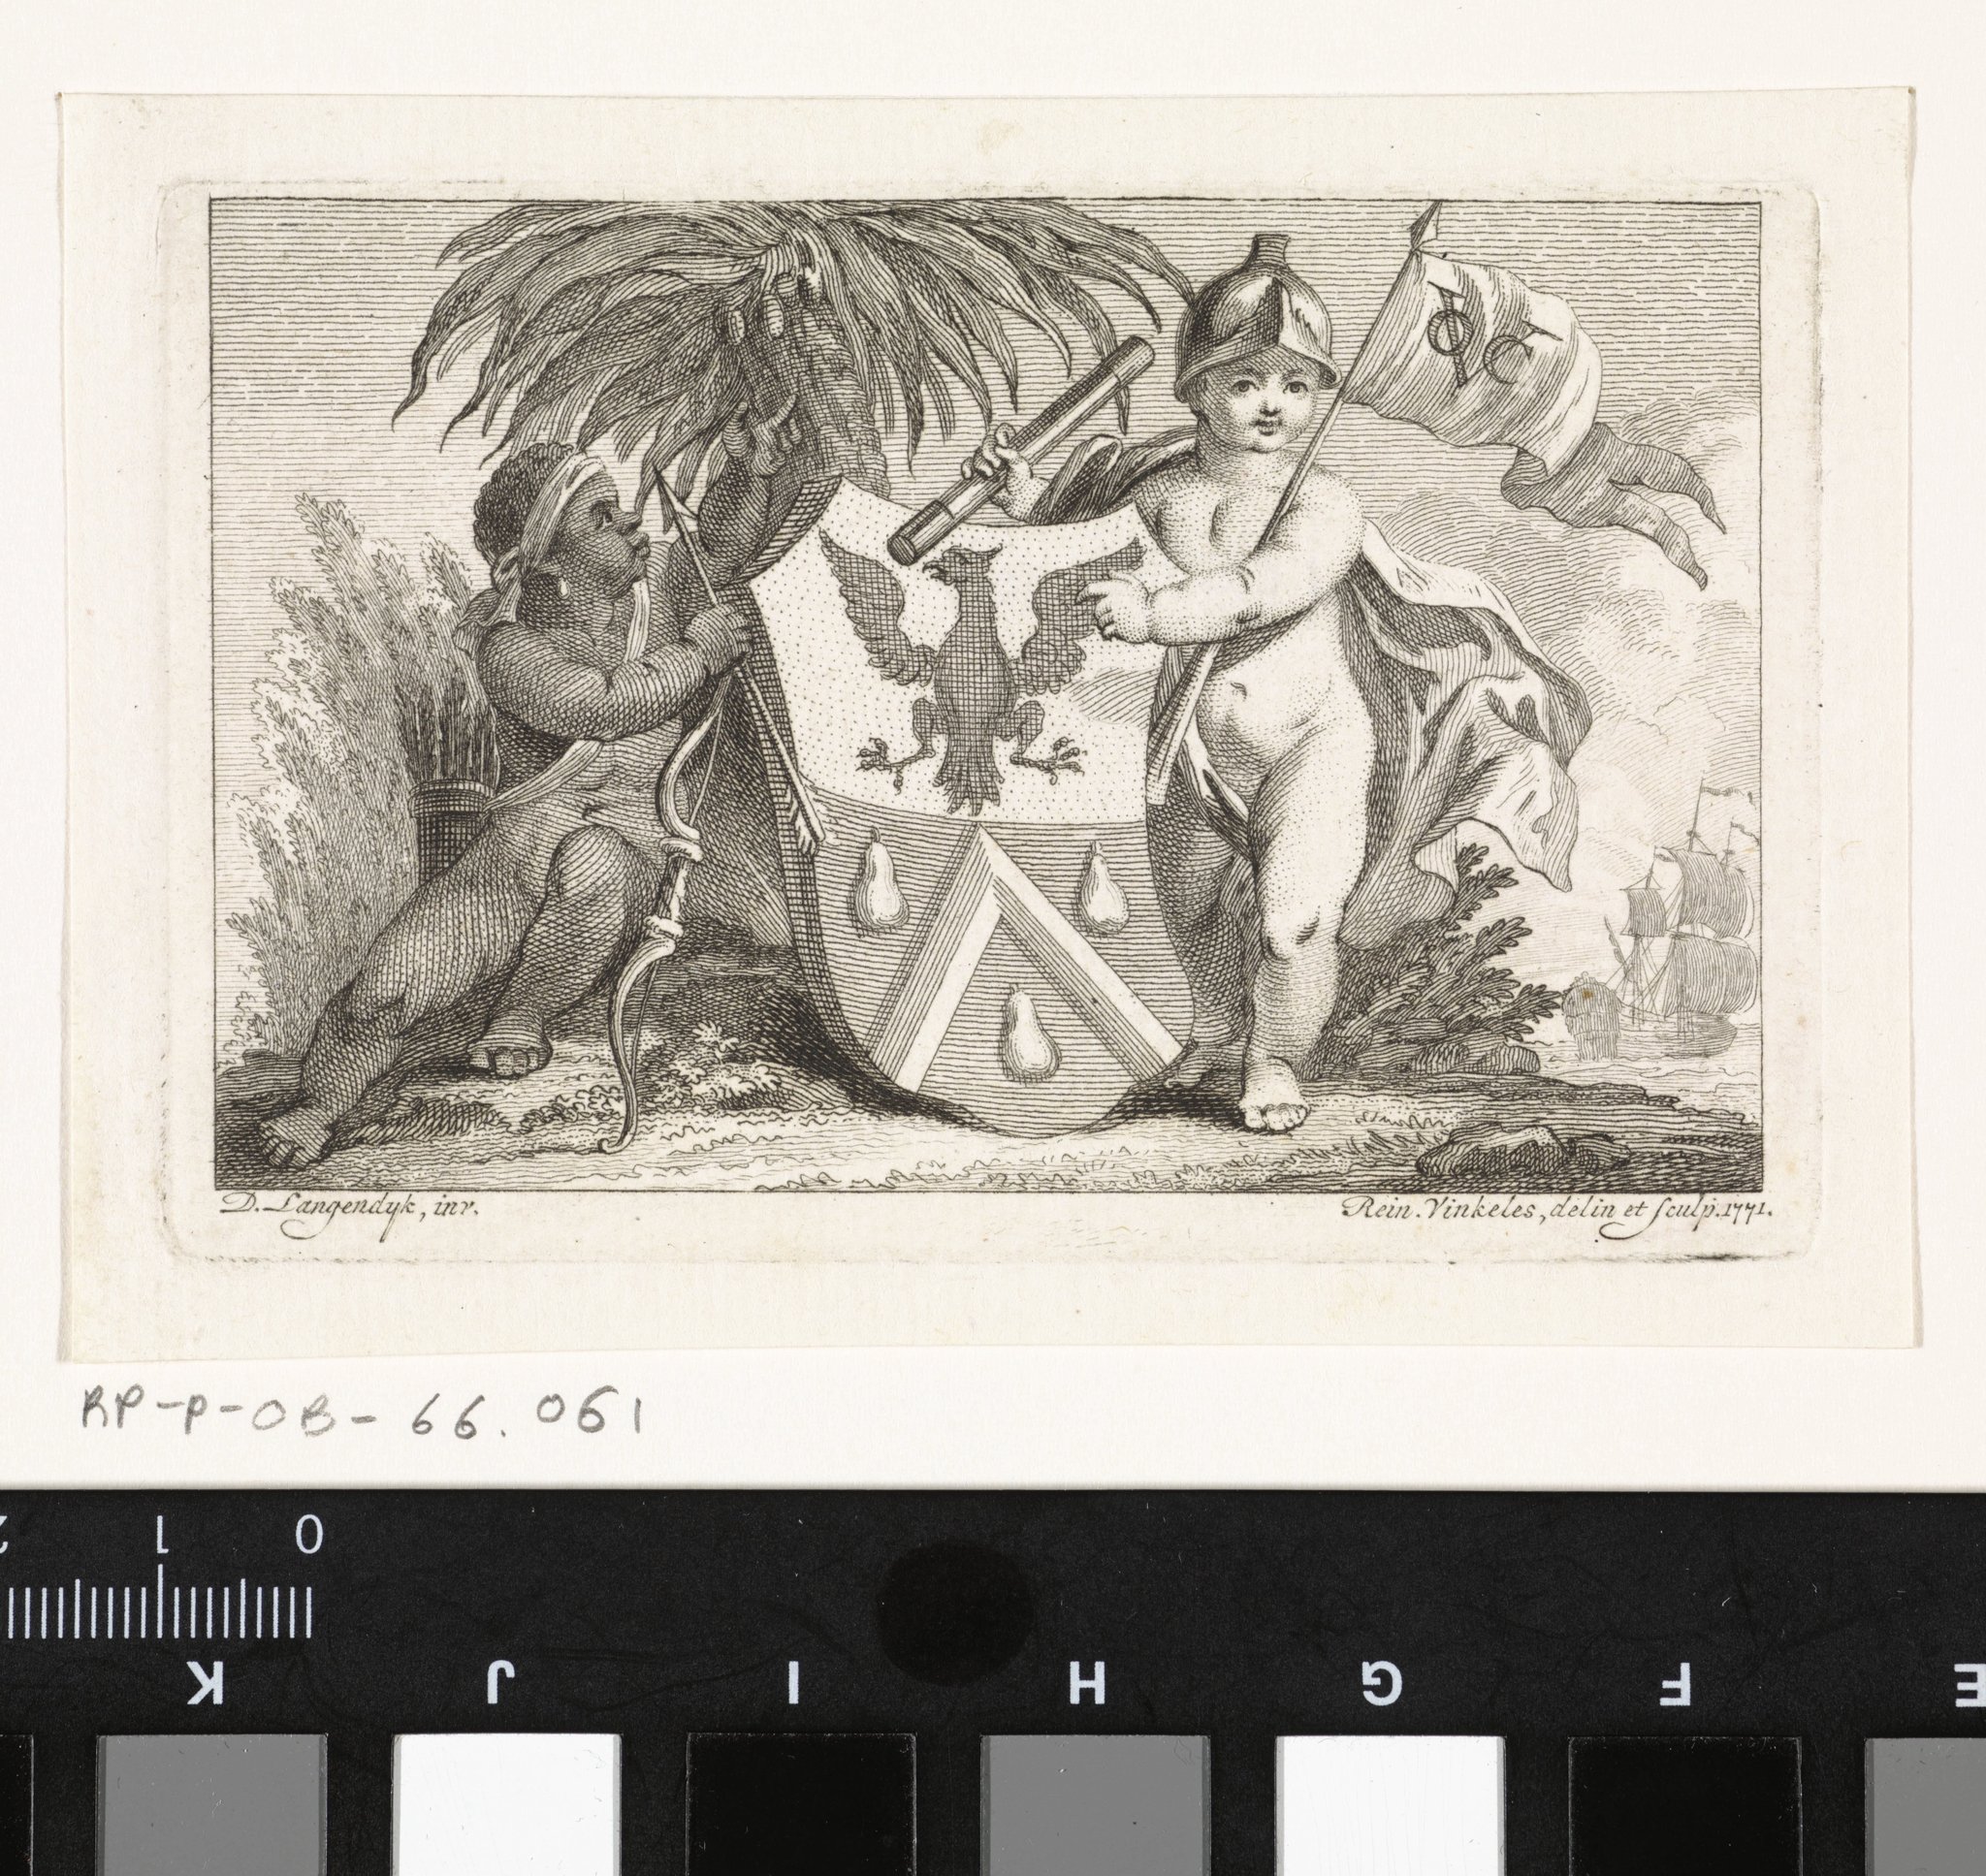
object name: print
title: Twee kinderen met het familiewapen van familie van der Parra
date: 1771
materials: paper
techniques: engraving, etching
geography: amsterdam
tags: sailing-ship, sailing-boat, africans, armorial bearing, heraldry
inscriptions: collector's mark: Lugt 240